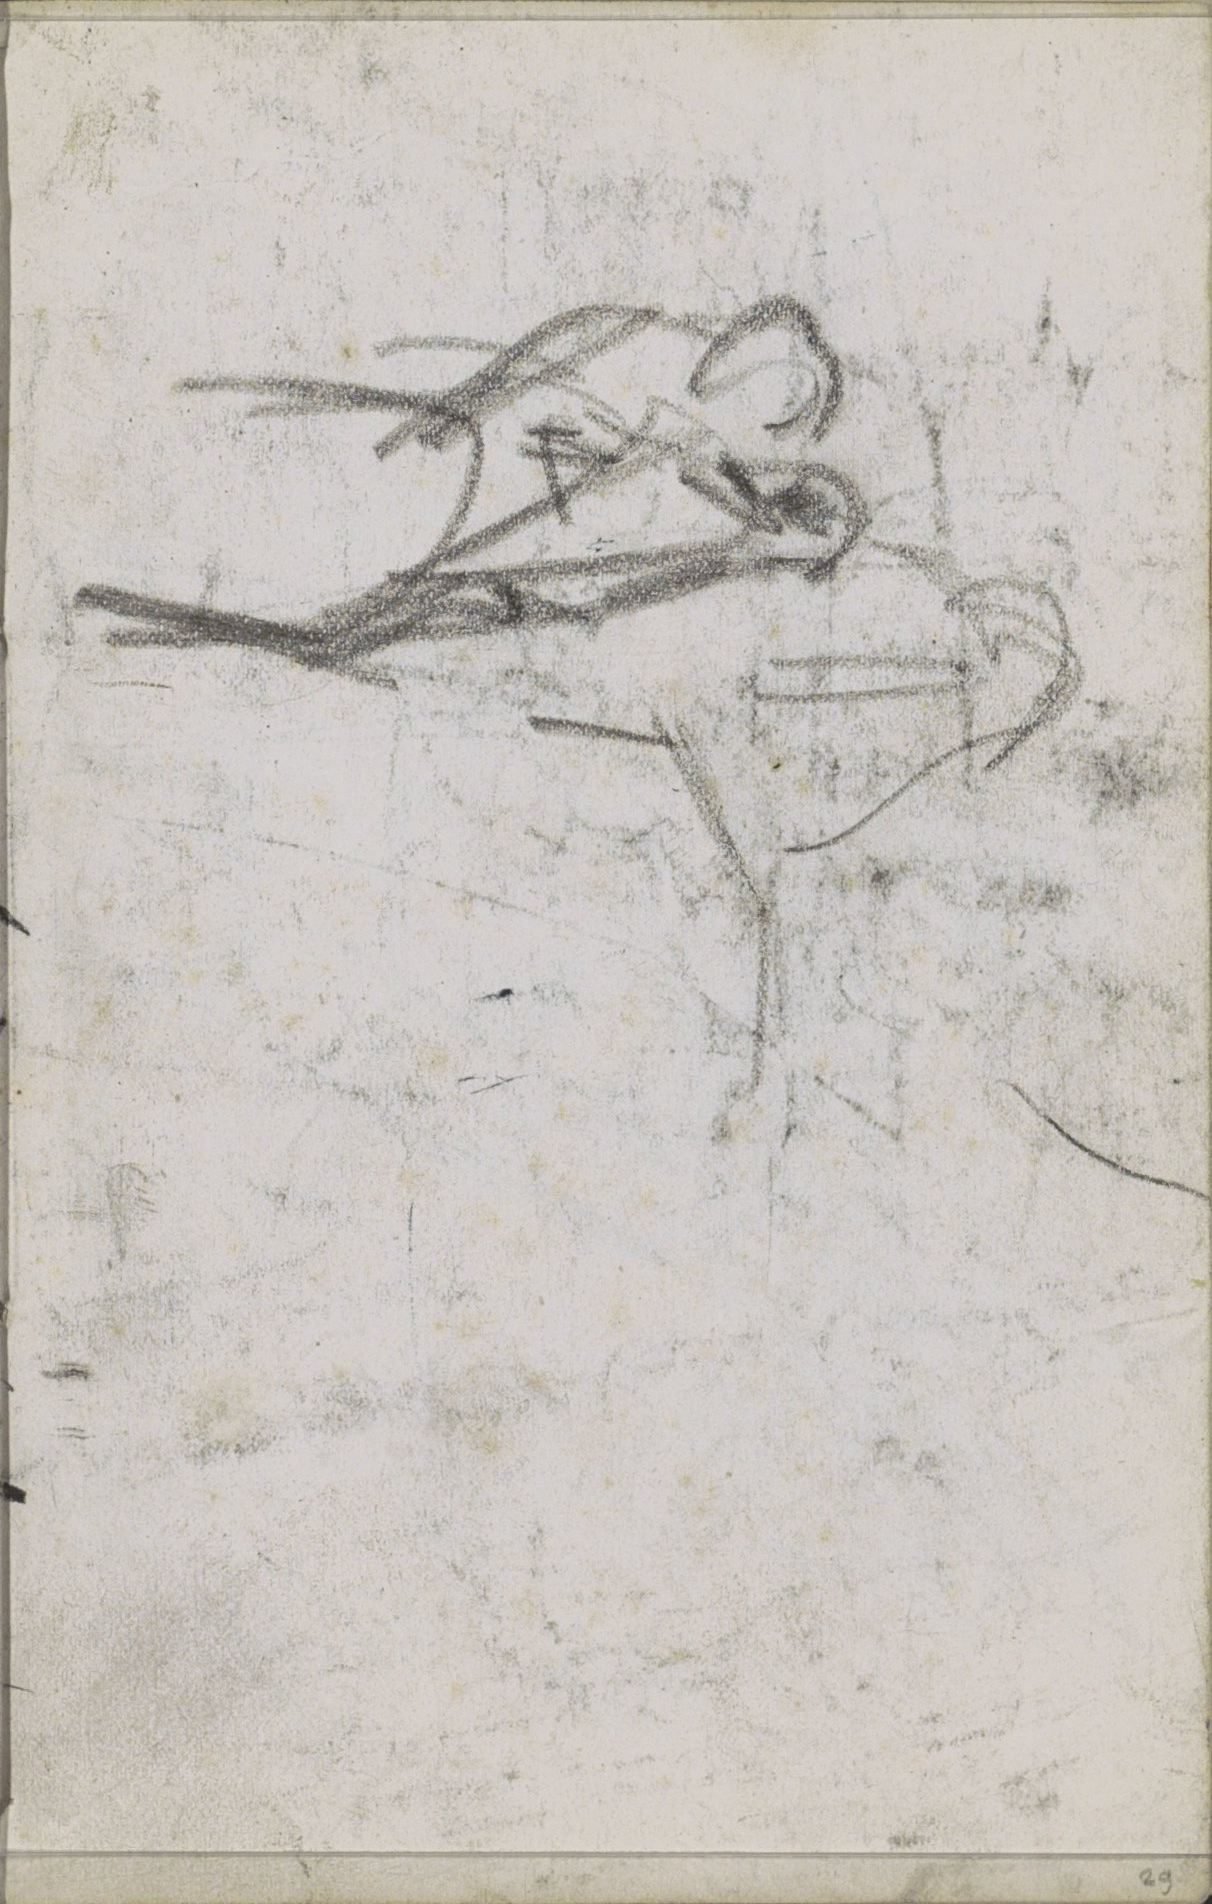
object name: sketchbook leaf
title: Figuurstudies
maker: isaac israels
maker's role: draughtsman, painter, print maker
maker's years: 1865-1934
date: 1875-1934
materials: chalk, paper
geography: amsterdam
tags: standing figure, adult woman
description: Pagina 29 uit schetsboek XXIX met 44 pagina's.